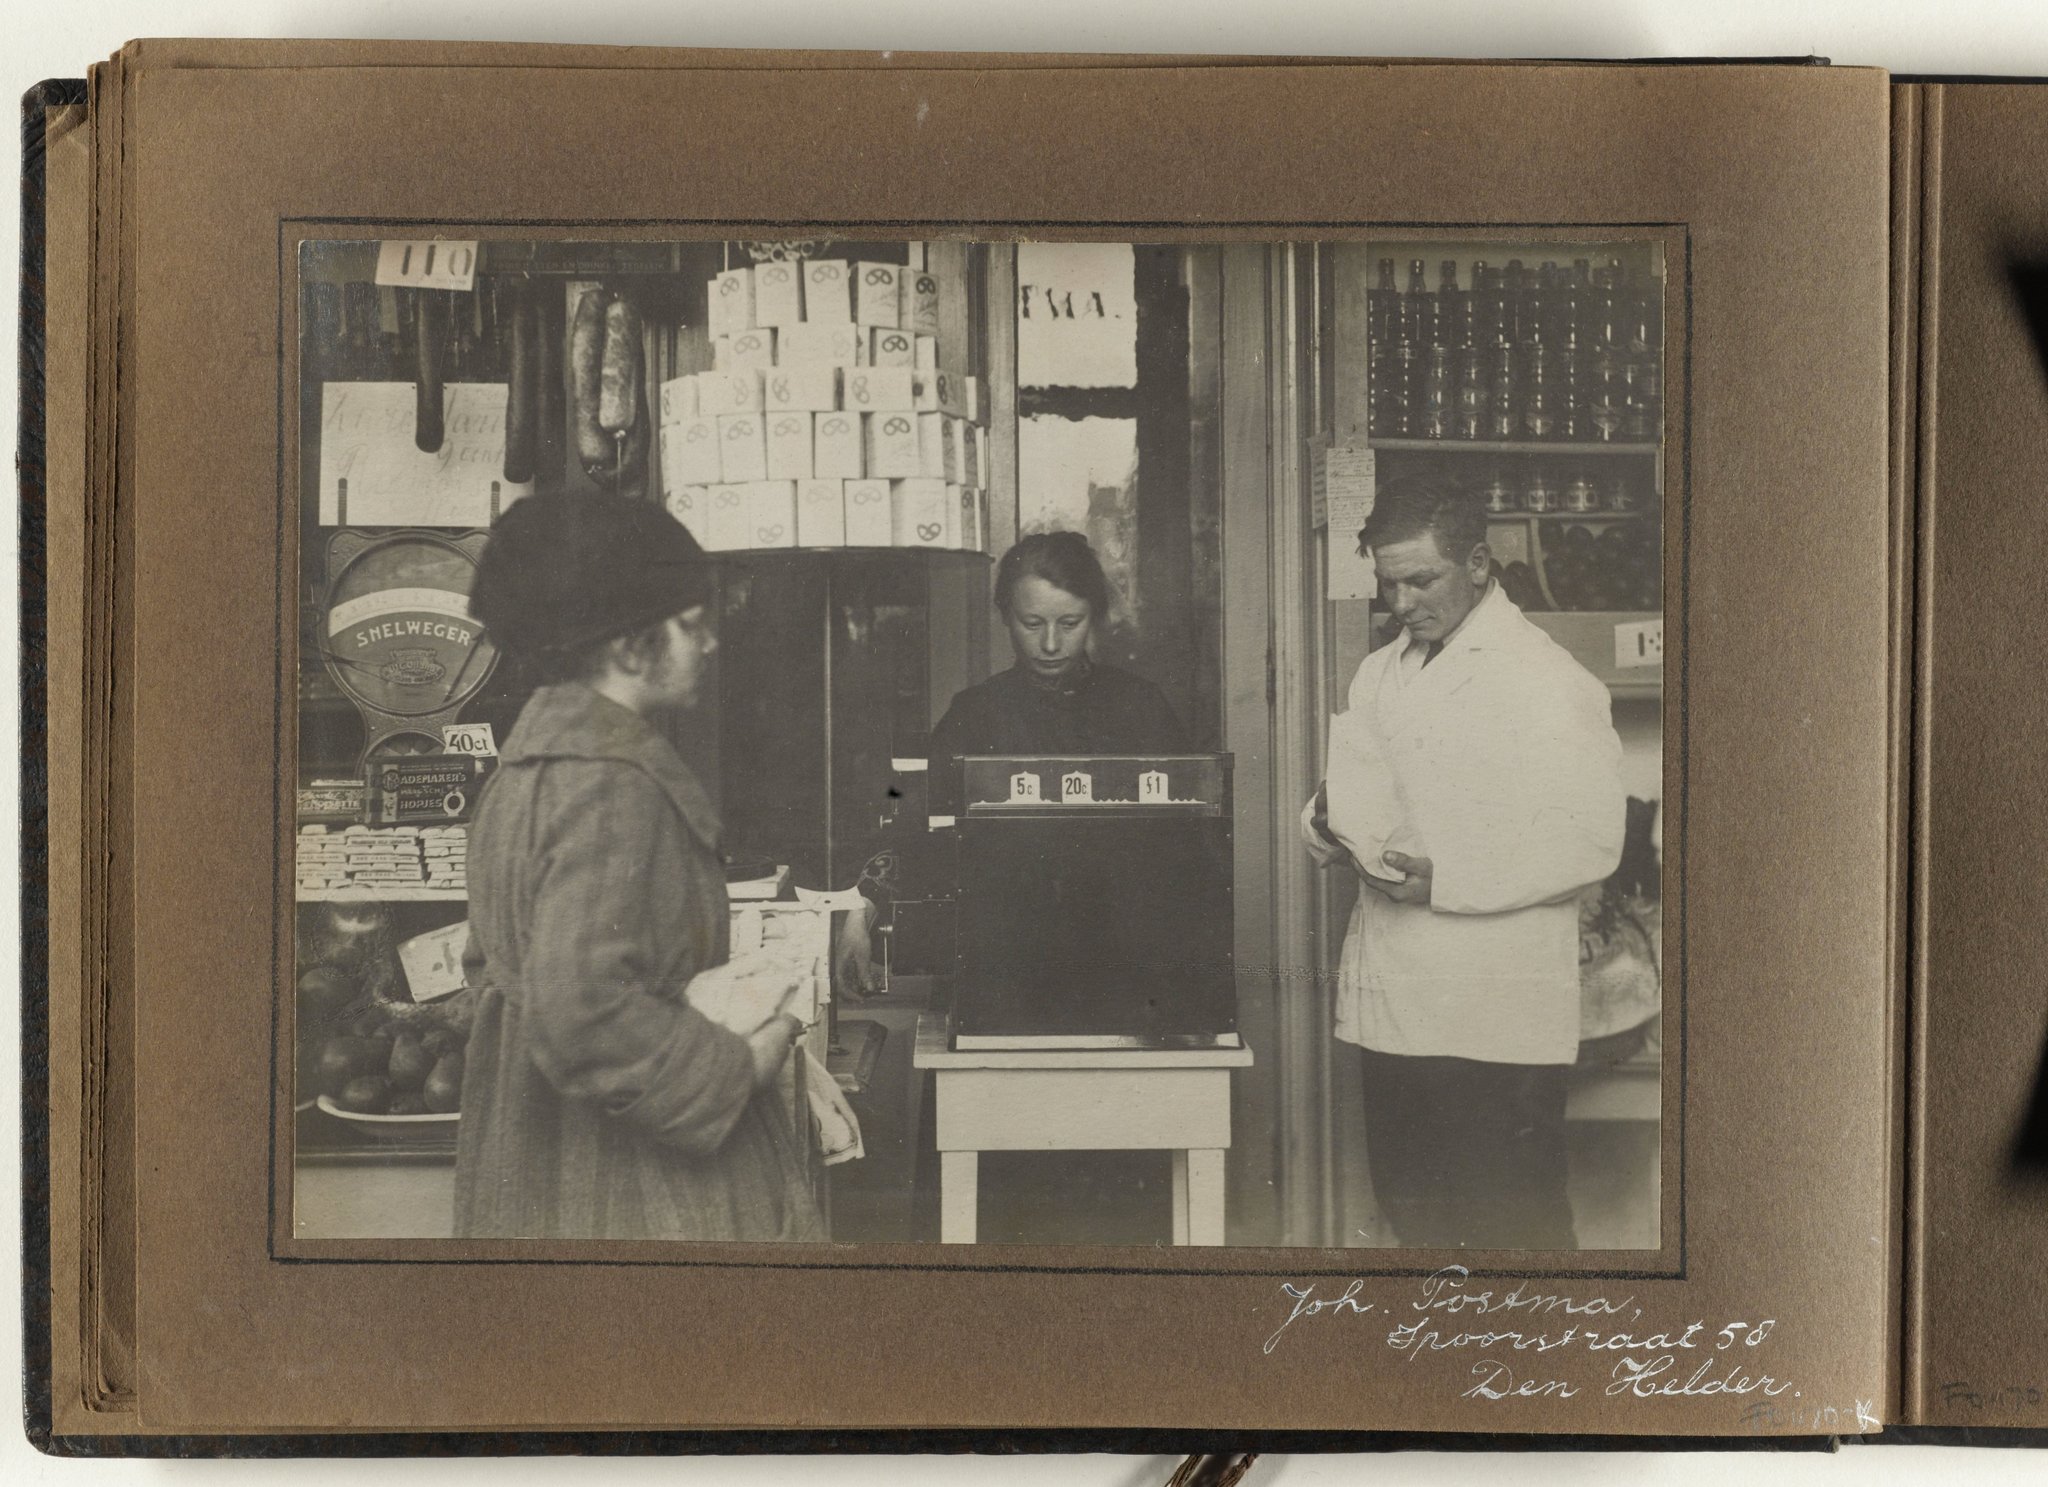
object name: album leaf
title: Joh. Postma, Spoorstraat 58, Den Helder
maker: Anonymous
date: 1925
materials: paper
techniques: gelatin silver print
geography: den helder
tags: shop, store, den helder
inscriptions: annotation: ‘Joh. Postma/ Spoorstraat 58/ Den Helder’